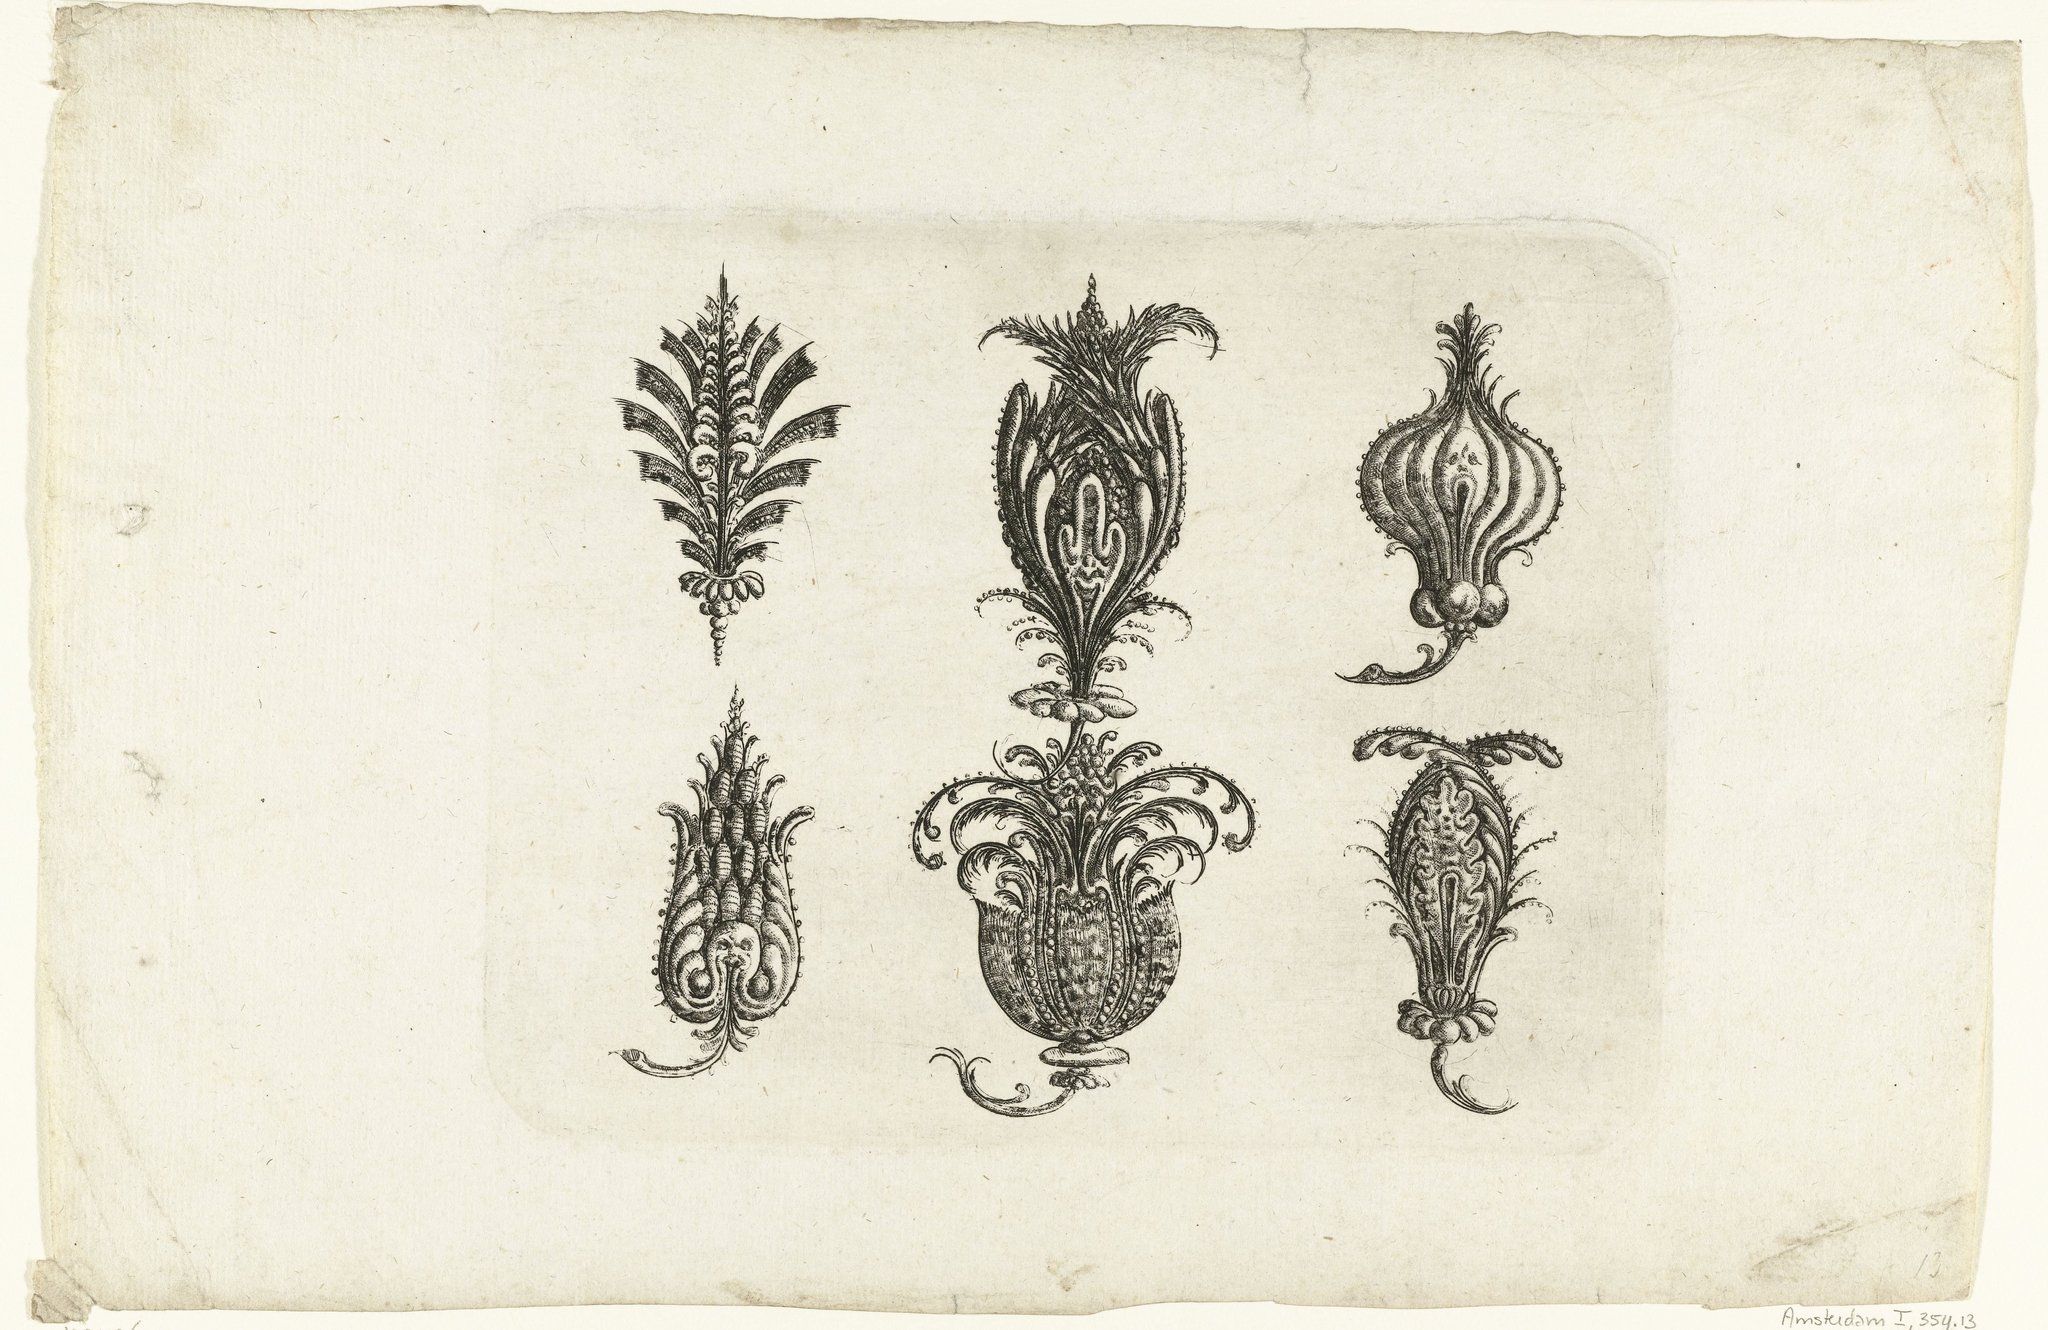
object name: ornament print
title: Zes fantasie-vruchten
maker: christoph jamnitzer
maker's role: draughtsman, goldsmith, print maker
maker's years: 1563-1618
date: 1573-1610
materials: paper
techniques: etching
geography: germany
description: Blad uit een serie vlakdecoraties met grotesken, cartouches, ovalen, mascarons, putti en fantastische wezens. De serie bestaat uit drie titelbladen, twee tekstbladen met de opdracht en het voorwoord en 60 bladen, verdeeld over drie boeken.